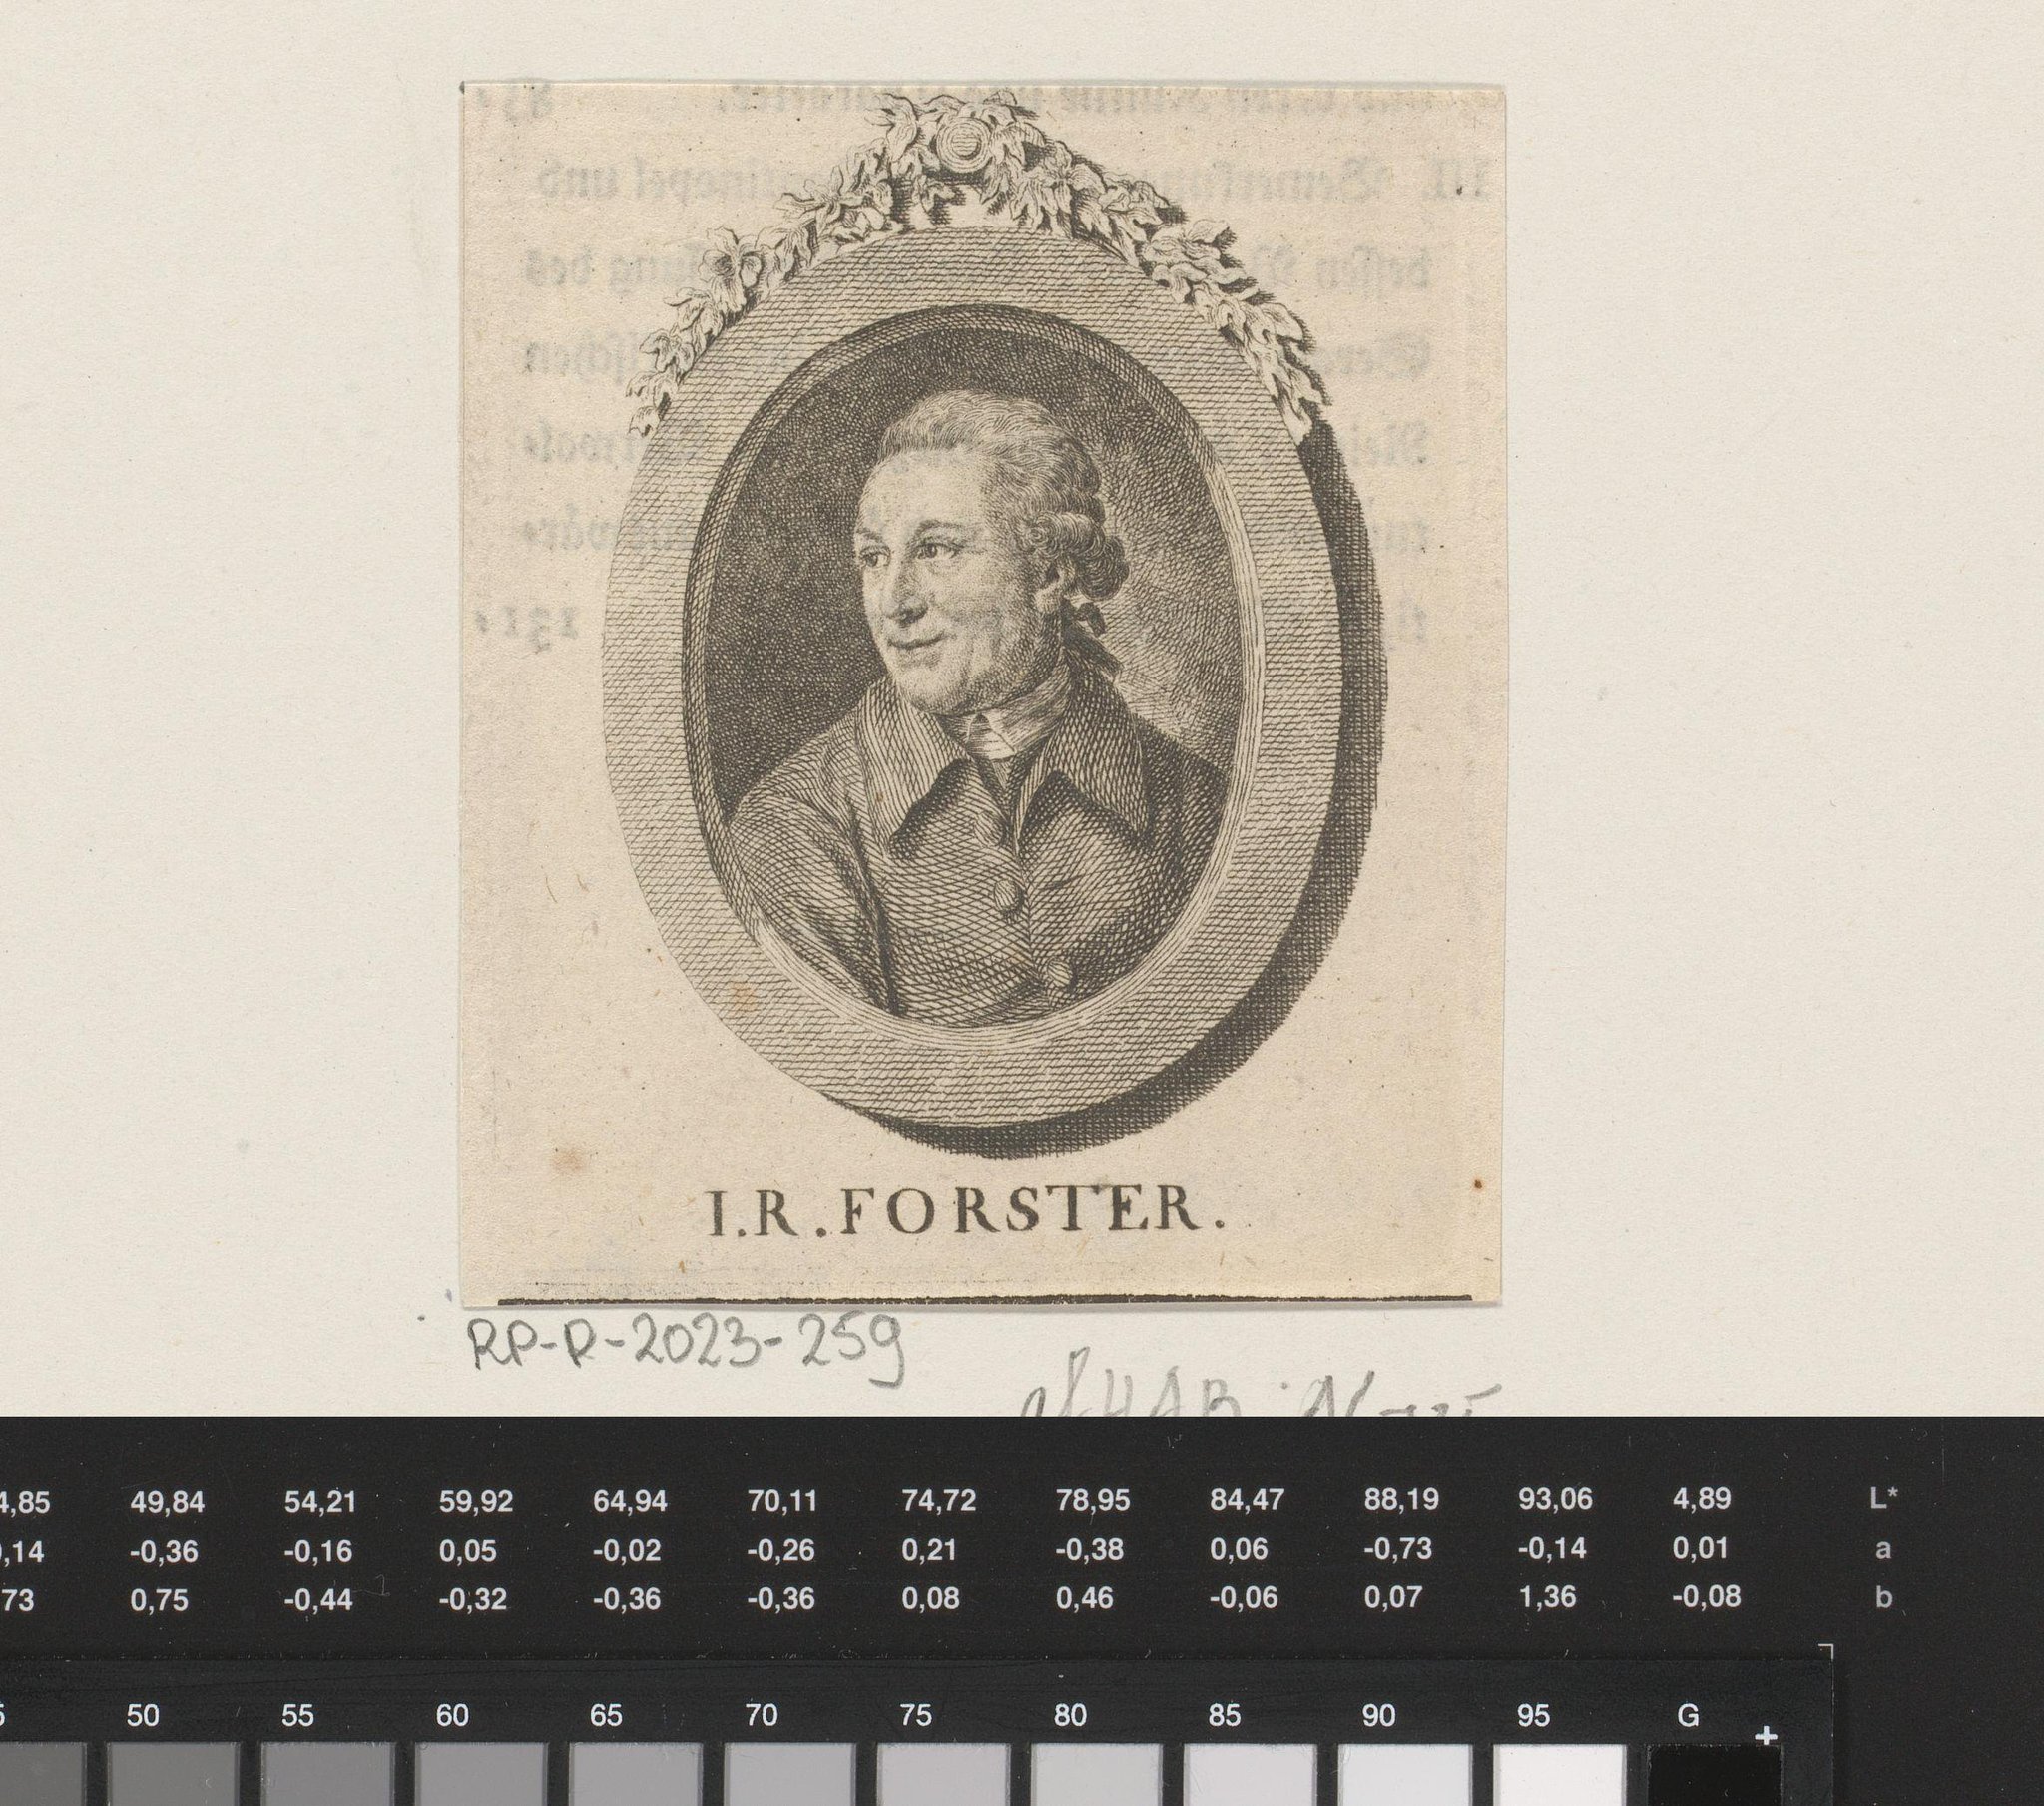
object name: book illustration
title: Portret van Johann Reinhold Forster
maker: Anonymous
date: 1780-1850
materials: paper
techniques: engraving, etching, letterpress printing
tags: johann reinhold forster, botany (+ portrait of scholar, scientist), historical persons